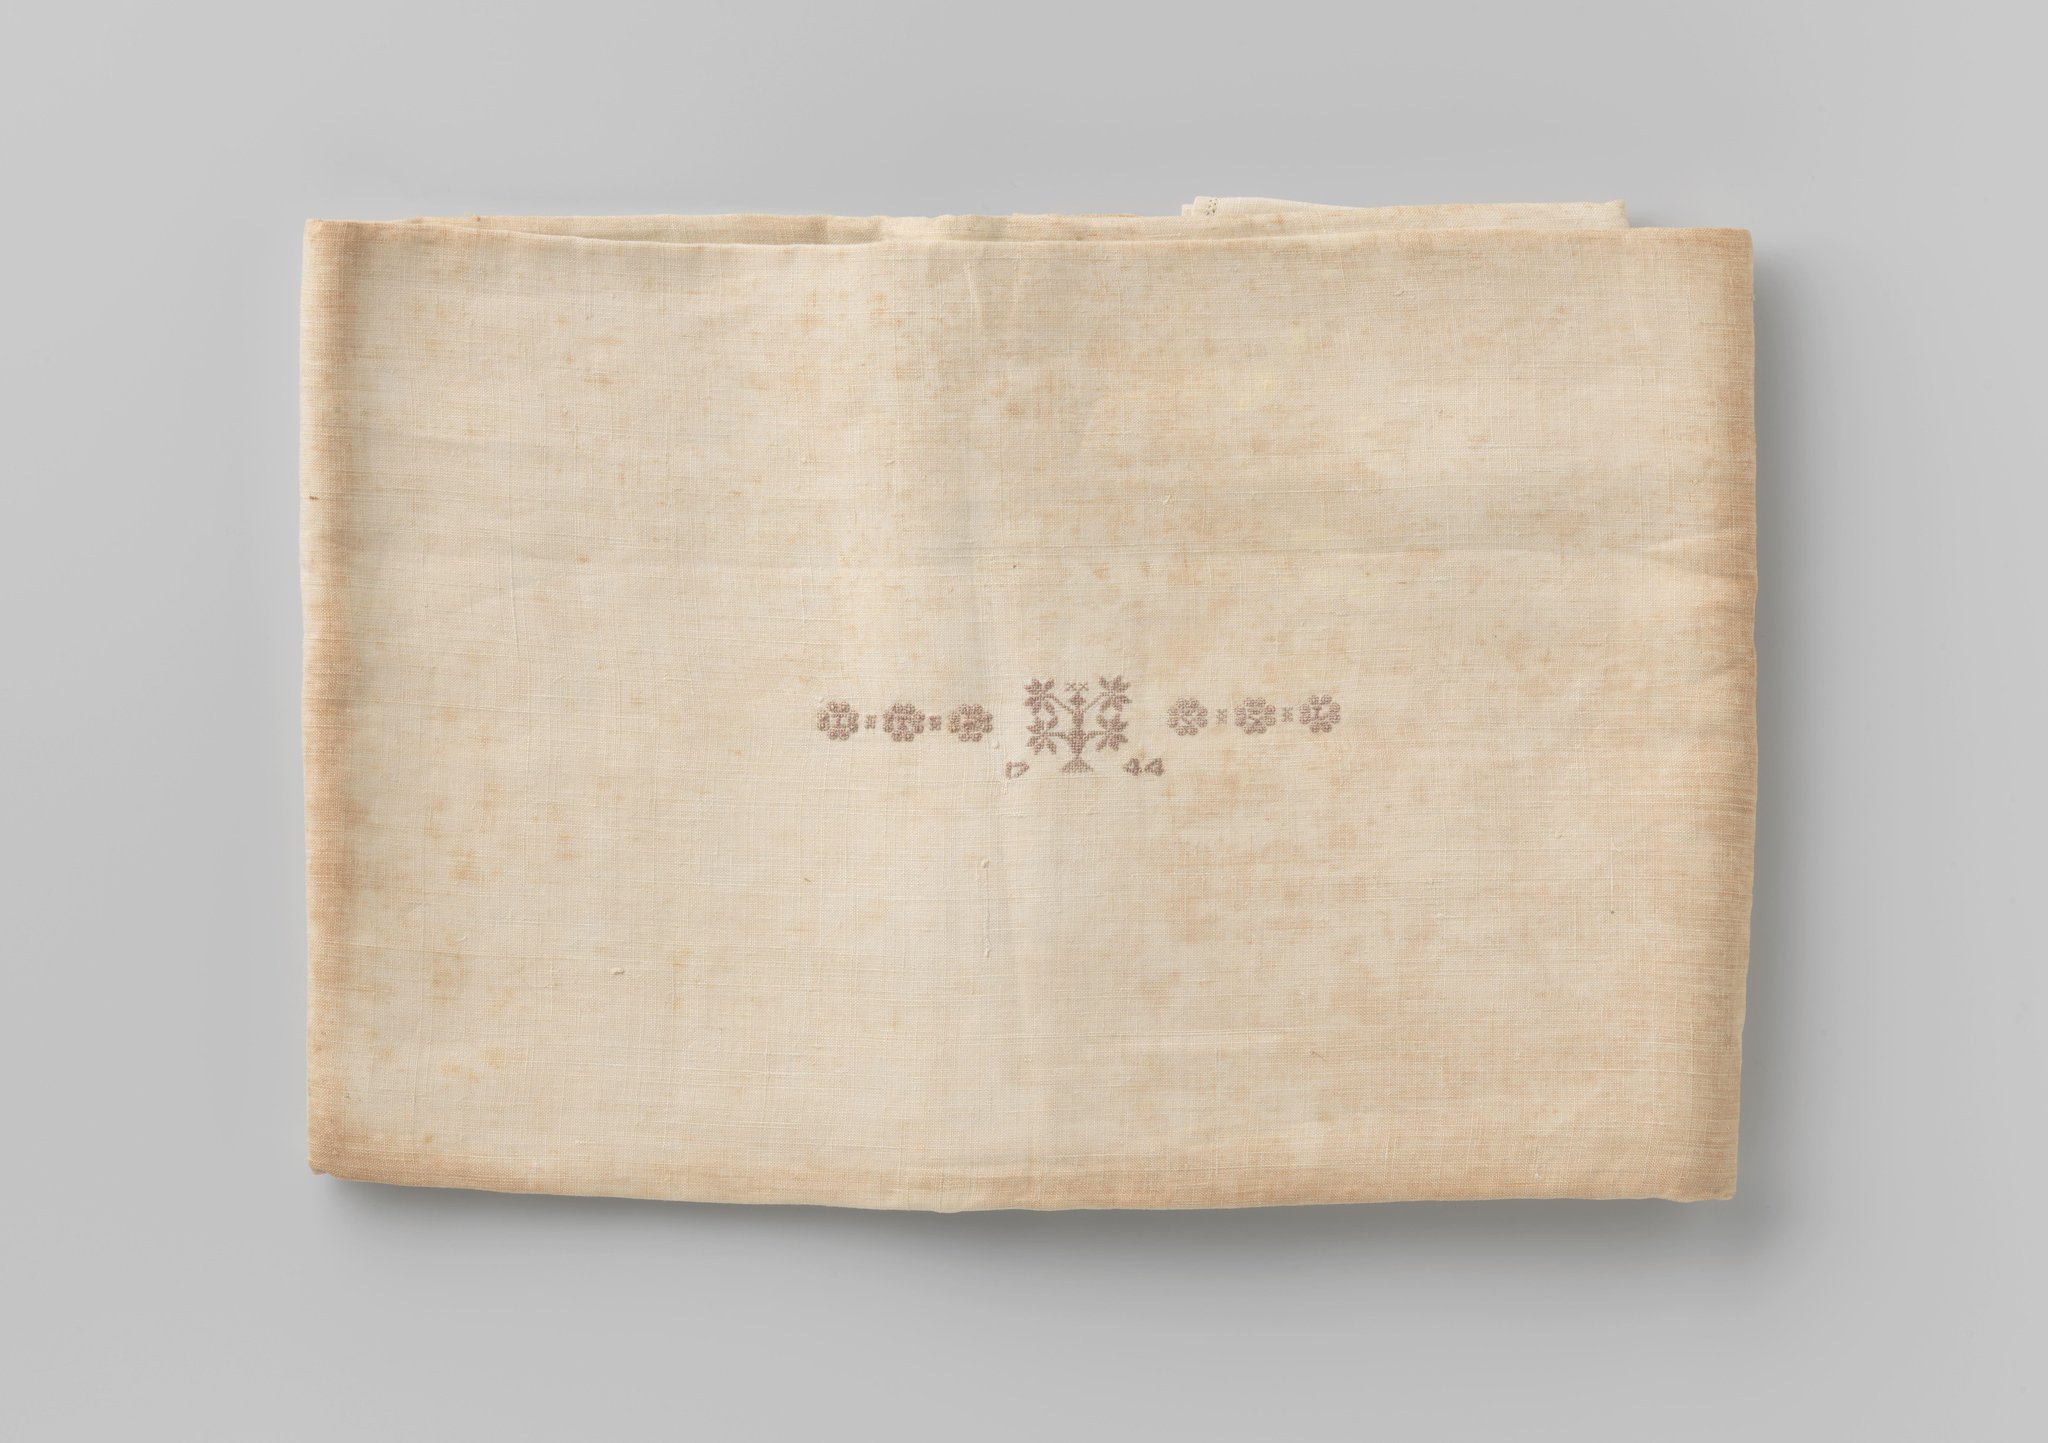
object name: beddenlaken, laken object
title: Laken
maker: Anonymous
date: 1744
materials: linen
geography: netherlands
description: Laken van wit heellinnen, met initialen ITS en CCL en het jaartal 1744.